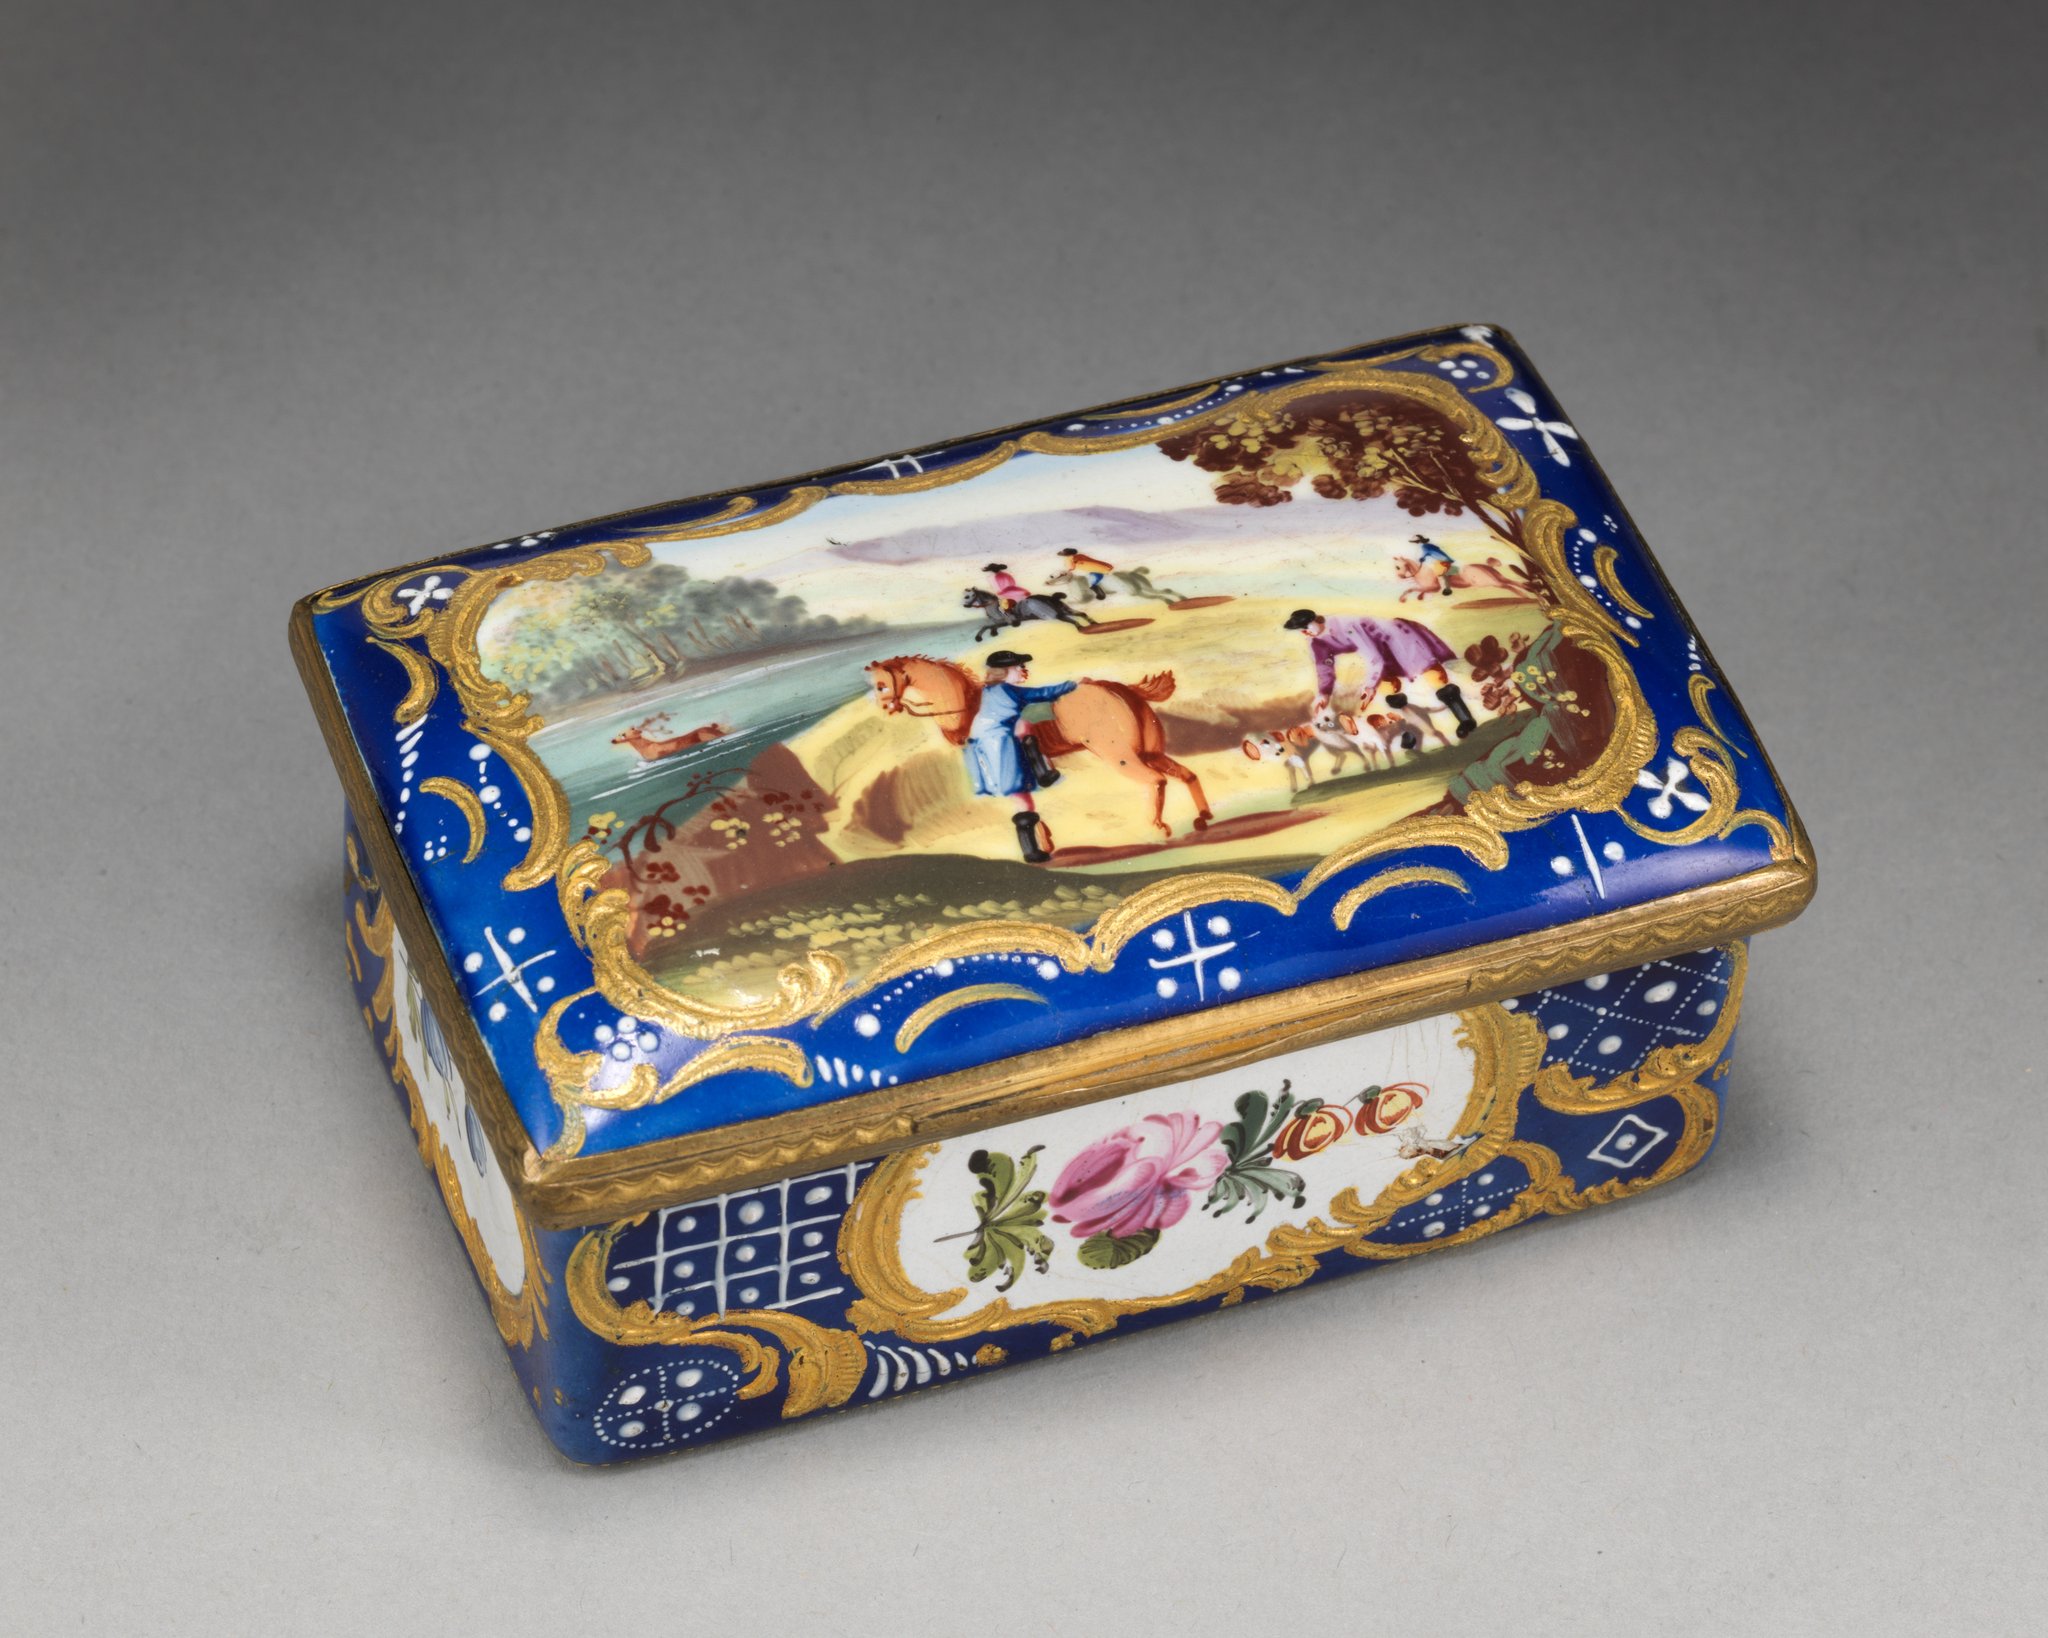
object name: snuffbox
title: Snuffbox with stag hunt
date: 1765-1770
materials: copper, enamel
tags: human figures,animals,flowers